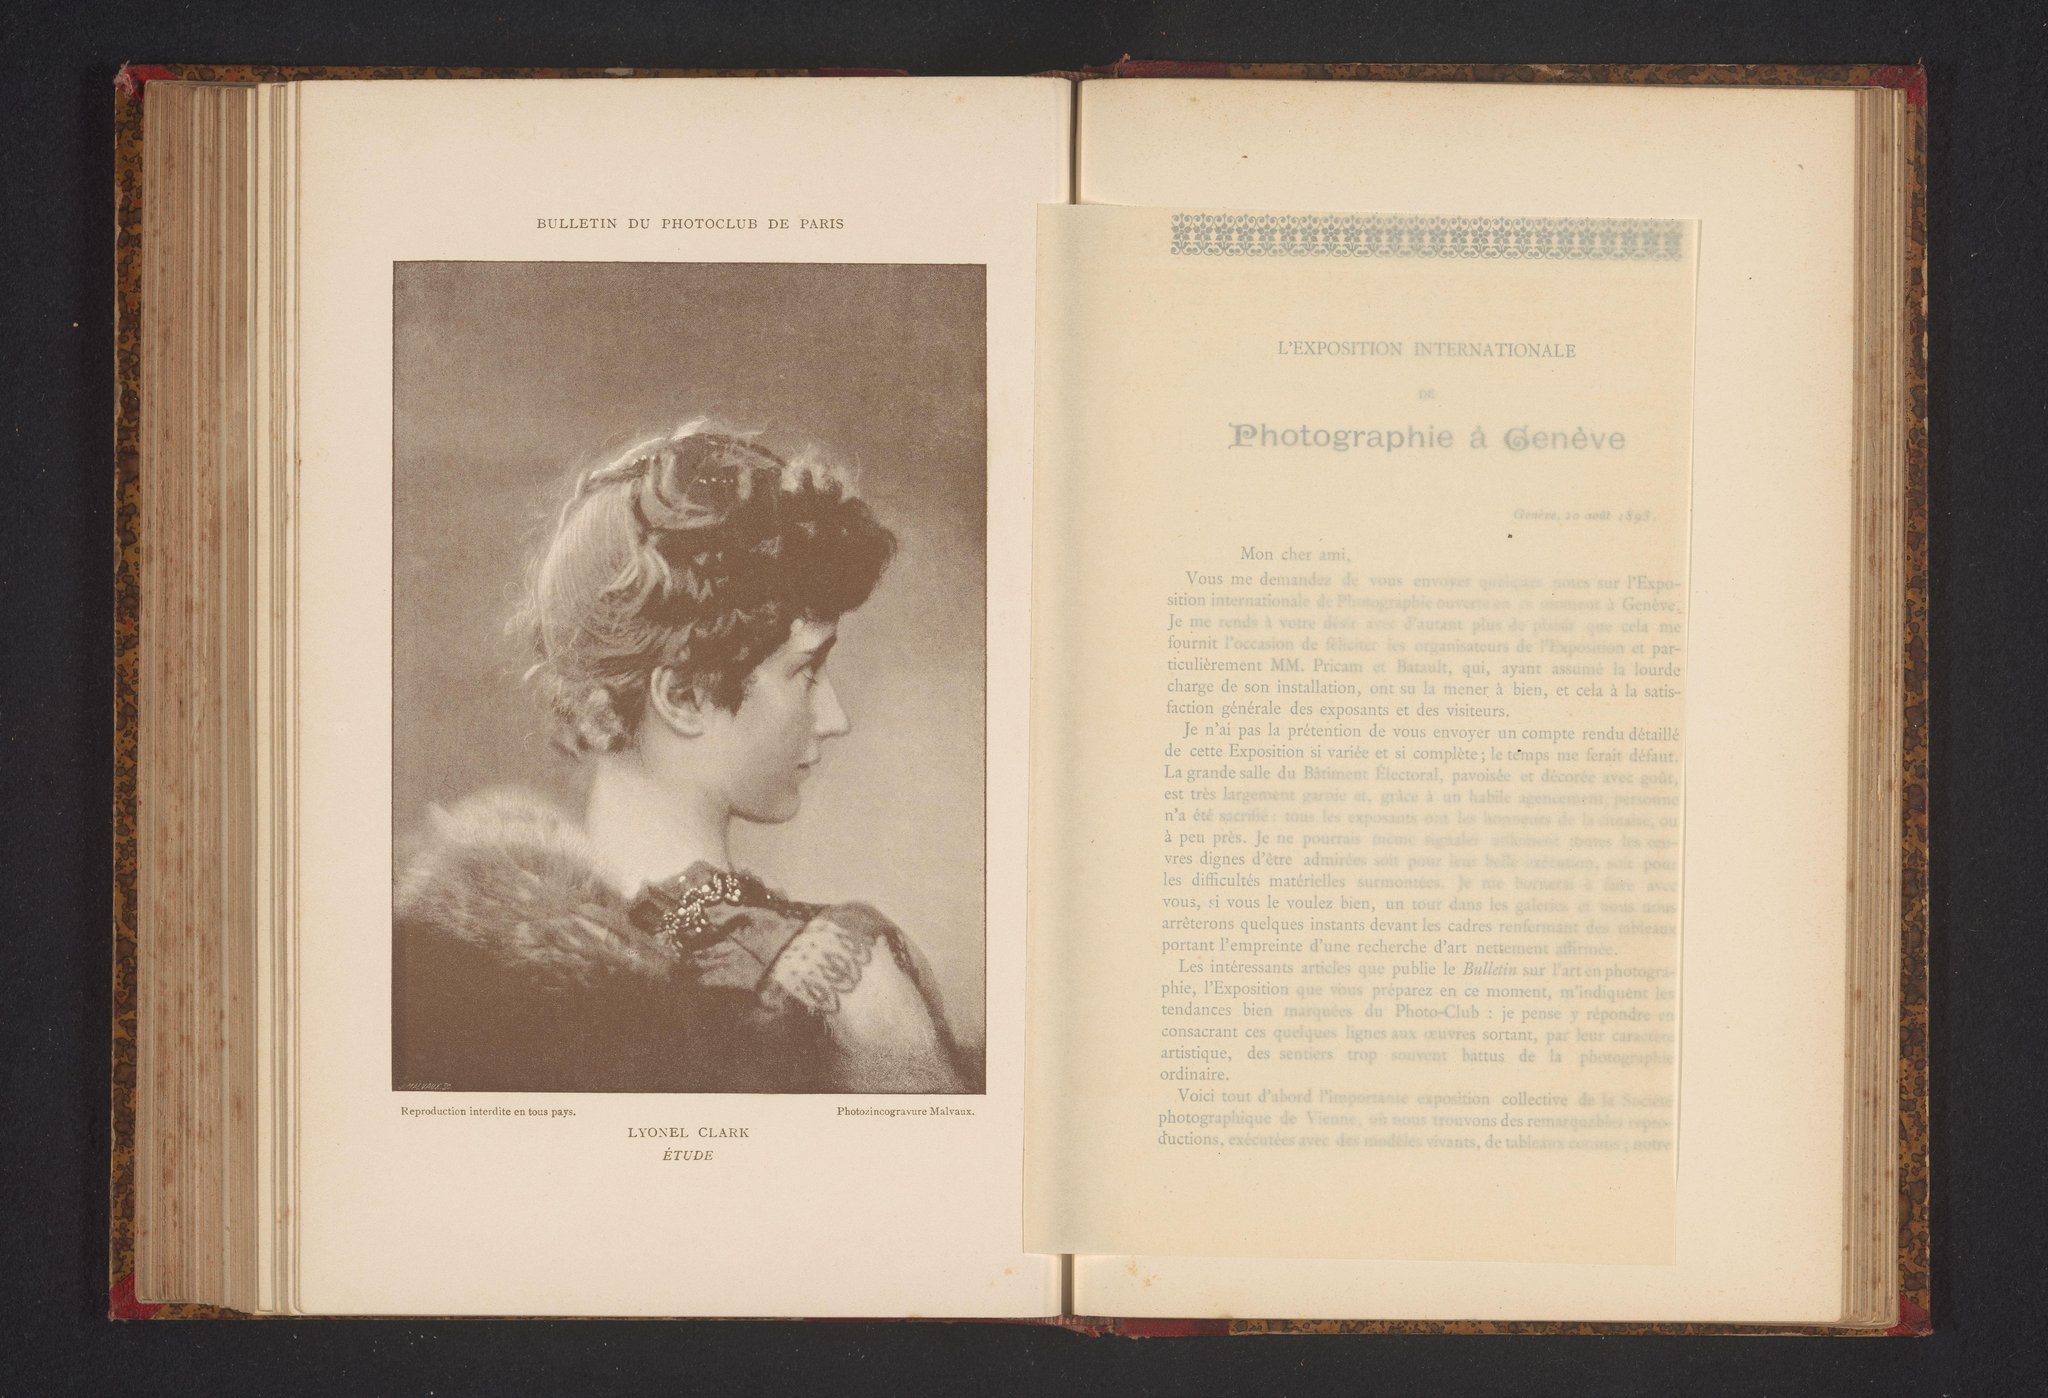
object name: photomechanical print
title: Étude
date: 1888-1893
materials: paper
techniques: autotype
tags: historical persons not known by name - bb - woman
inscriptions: inscription: ‘Reproduction interdite en tous pays.’, inscription: ‘Bulletin du Photoclub de Paris’